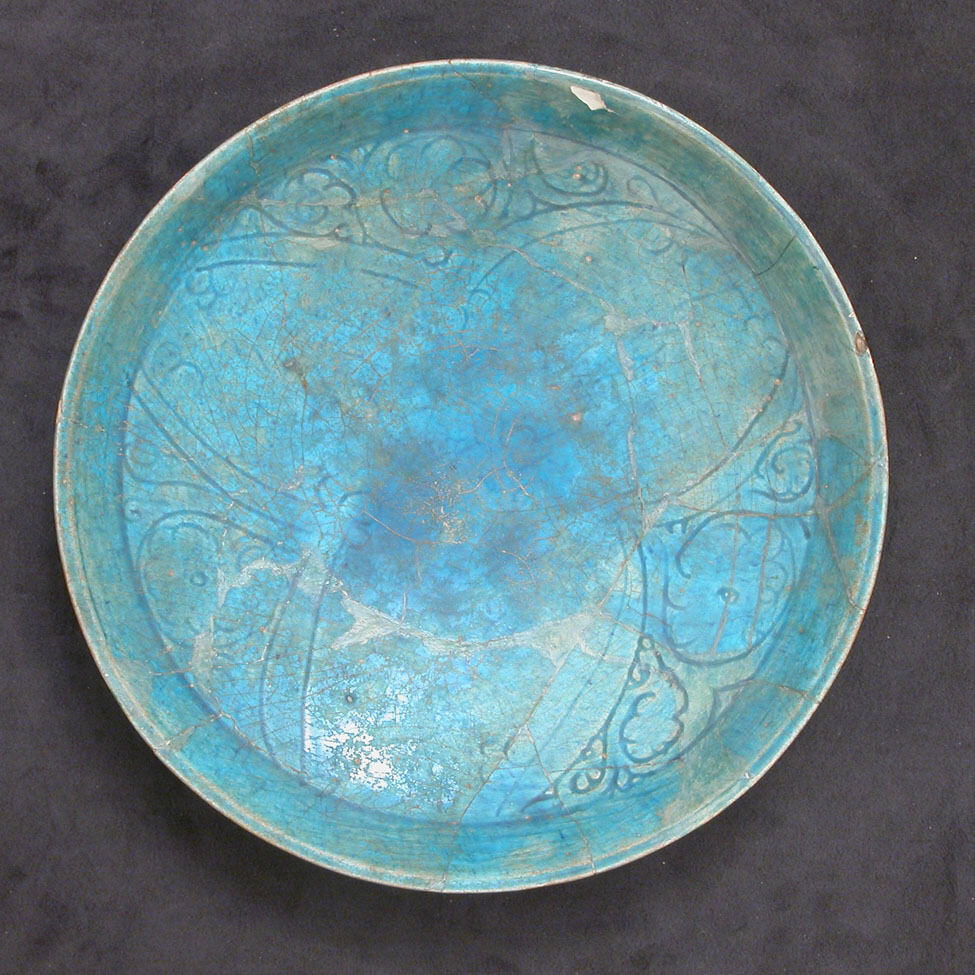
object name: dish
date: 1101-1200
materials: stonepaste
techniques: glazing, incising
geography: iran